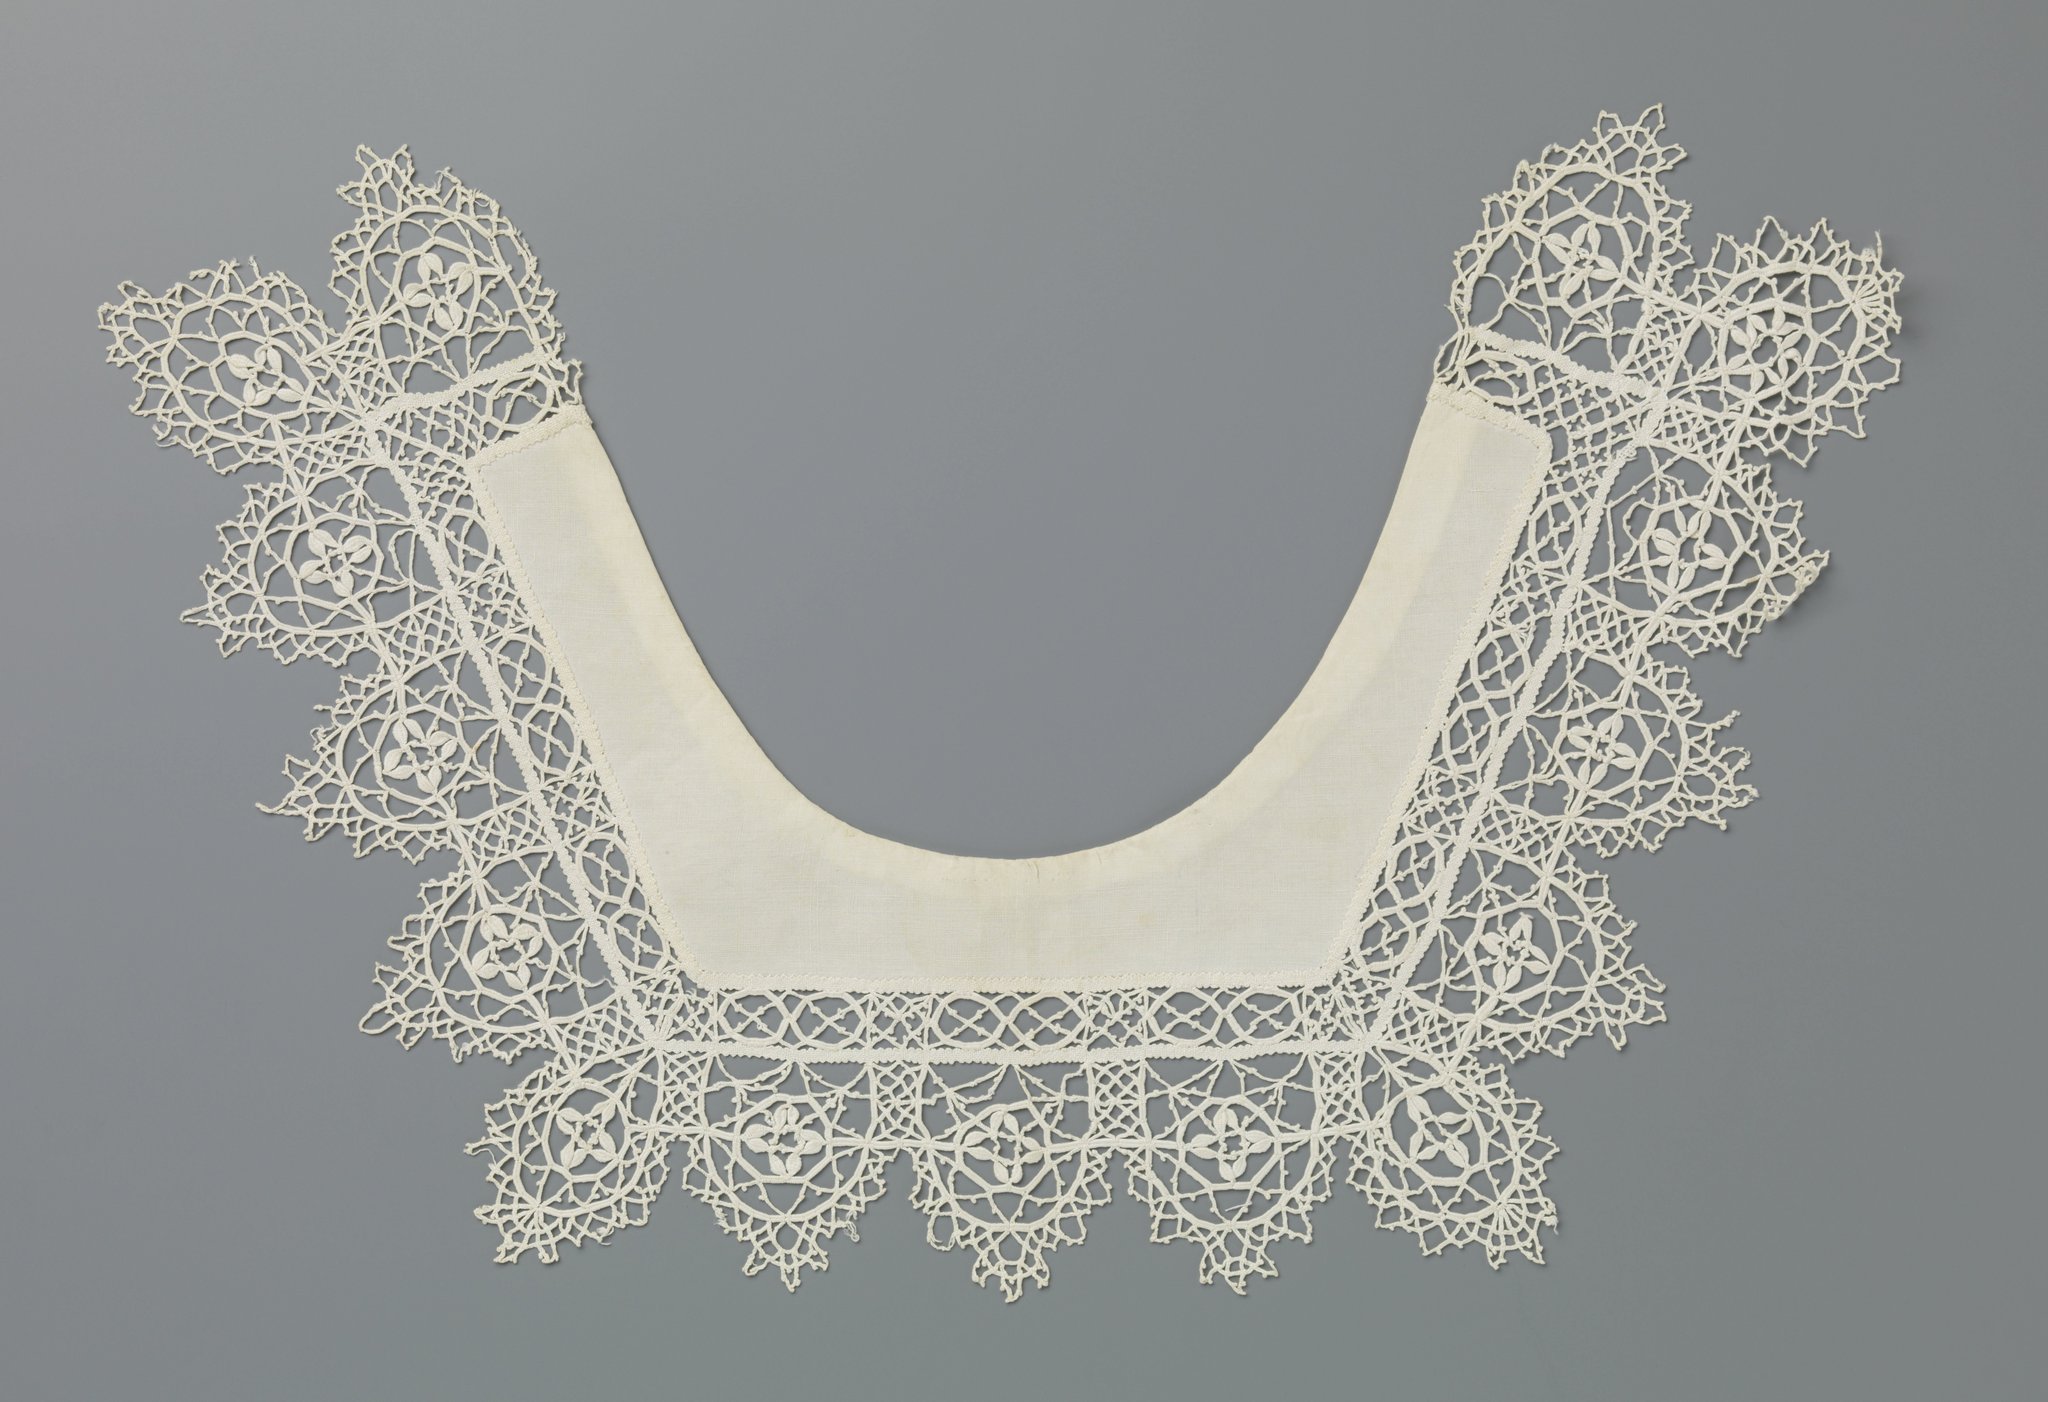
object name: womenswear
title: Kraag van kloskant geïnspireerd op liggende 17e eeuwse kragen en bijbehorende verlovingsfoto (kopie) van Bram Pleging en Jet Faber die de kraag maakte en droeg tijdens haar verloving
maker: jet pleging-faber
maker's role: kantwerkster, leraar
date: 1914-1916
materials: linen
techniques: lace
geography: amsterdam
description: Kraag van linnen met een rand naturelkleurig kloskant. Trapeziumvormig liggend model, met u-vormige halsopening. Het zich herhalende patroon bestaat uit halfovale schulpen, met in het centrum een vierlobbig rozet van acht spitsovale blaadjes, gemaakt in vormslag. Het rozet staat in het centrum van een gevlochten wiel met acht punten die een ster vormen. De schulpen zijn afgewerkt met gepicoteerde puntvlechten. De vier hoekschulpen, twee achter en twee van voren, zijn ei-vormig ingepast. Het geheel is geïnspireerd op een type liggende kraag, die in de 17e eeuw populair was. De maakster van de kraag, Johanna Henriëtte Faber (Jet), volgde Louise Van der Meulen-Nulle op als kantdocent aan de Rijksschool voor Kunstnijverheid in 1916. De kraag draagt ze in datzelfde jaar bij haar verloving met Abraham Pleging (Bram). De kraag is op de foto te zien, die bij deze gelegenheid van het verlovingspaar is gemaakt en waarvan een kopie bij de kanten kraag is geschonken. Er is ook een origineel fotoportret van Johanna Henriëtte Faber waarop ze de kraag draagt.